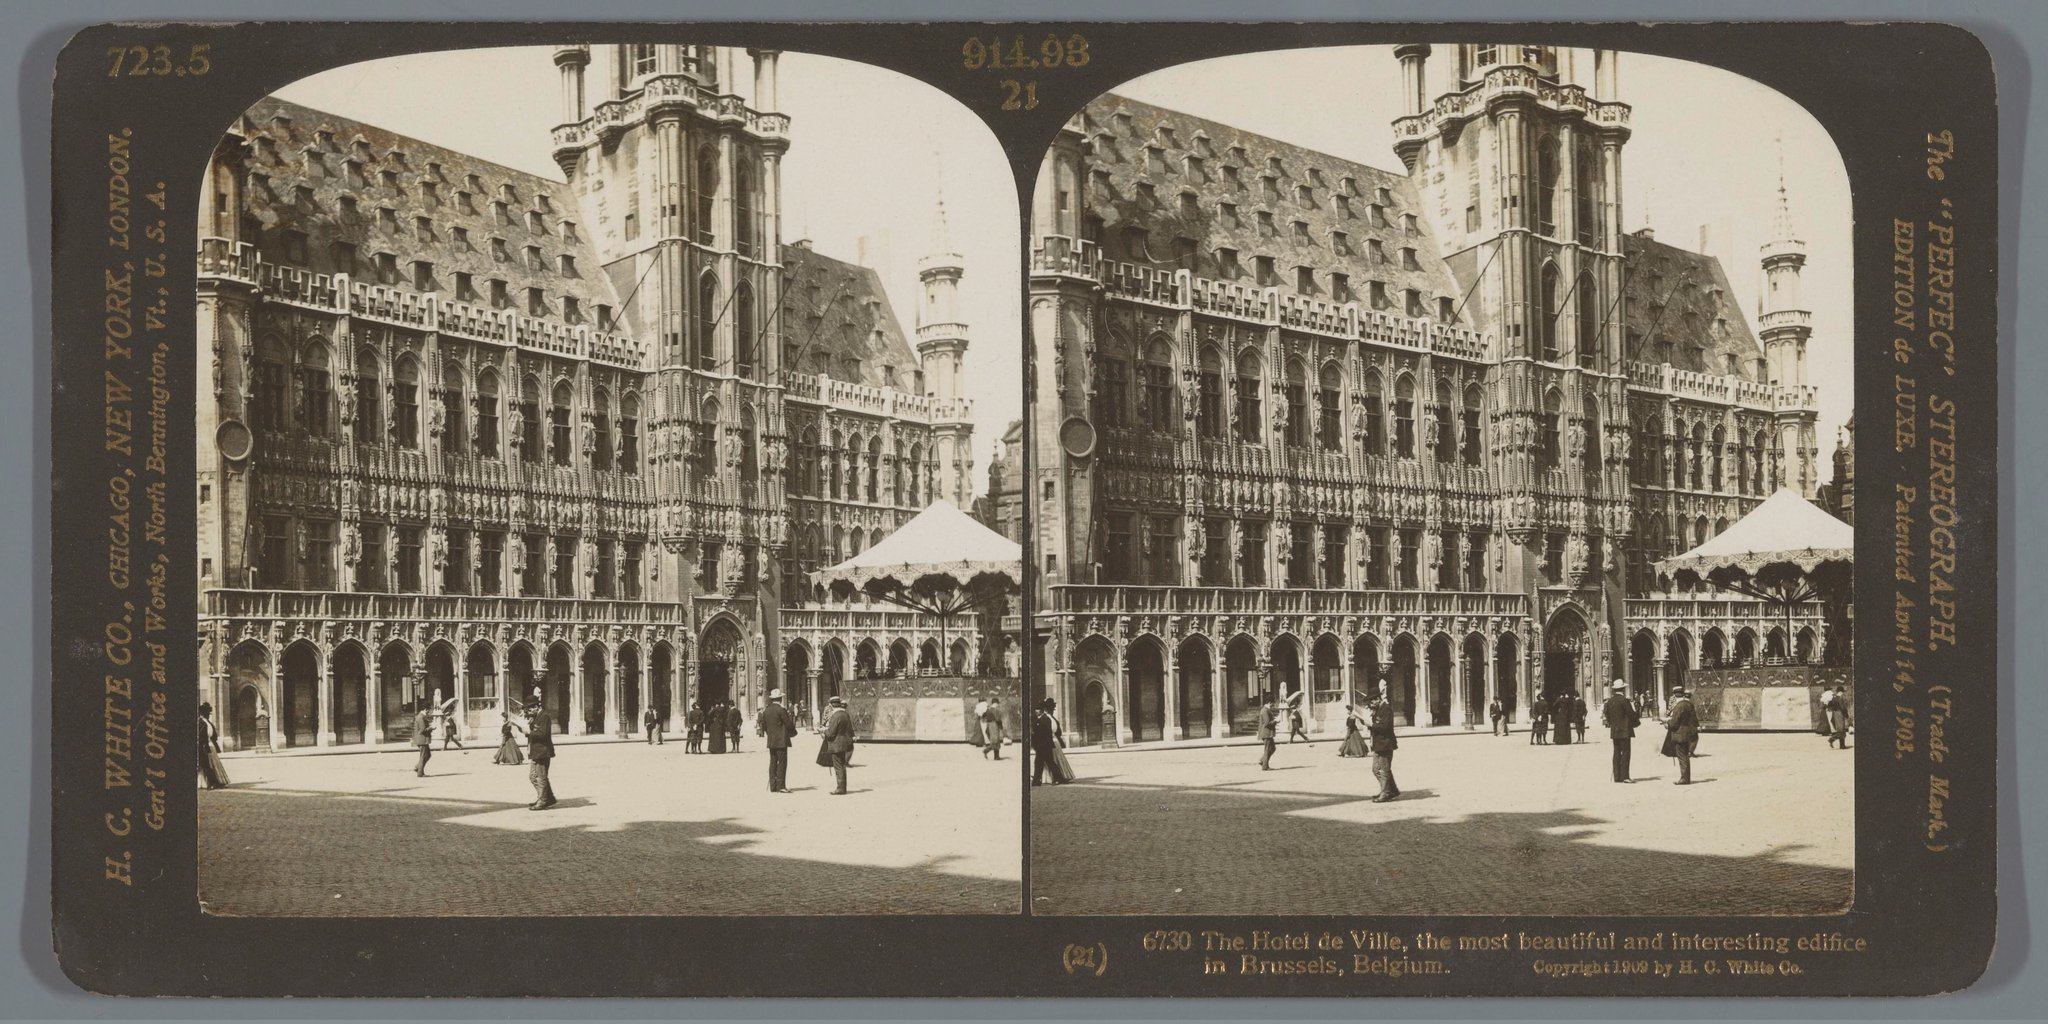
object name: stereograph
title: The Hotel de Ville, the most beautiful and interesting edifice in Brussels, Belgium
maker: Anonymous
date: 1909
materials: cardboard, photographic support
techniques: gelatin silver print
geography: brussels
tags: townhall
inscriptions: number: ‘723.5’, inscription: ‘The " PERFEC" STEREOGRAPH. (Trade Mark.)/ EDITION de LUXE. Patented April 14, 1903.’, number: ‘6730’, number: ‘(21)’, number: ‘9’, inscription: ‘All Perfec-Stereograph subjects may be secured in Lantern Slides and Enlargements.’, inscription: ‘Juli-Augustus 1910’, number: ‘914.93/ 21’, copyright notice: ‘Copyright 1909 by H. C. White Co.’